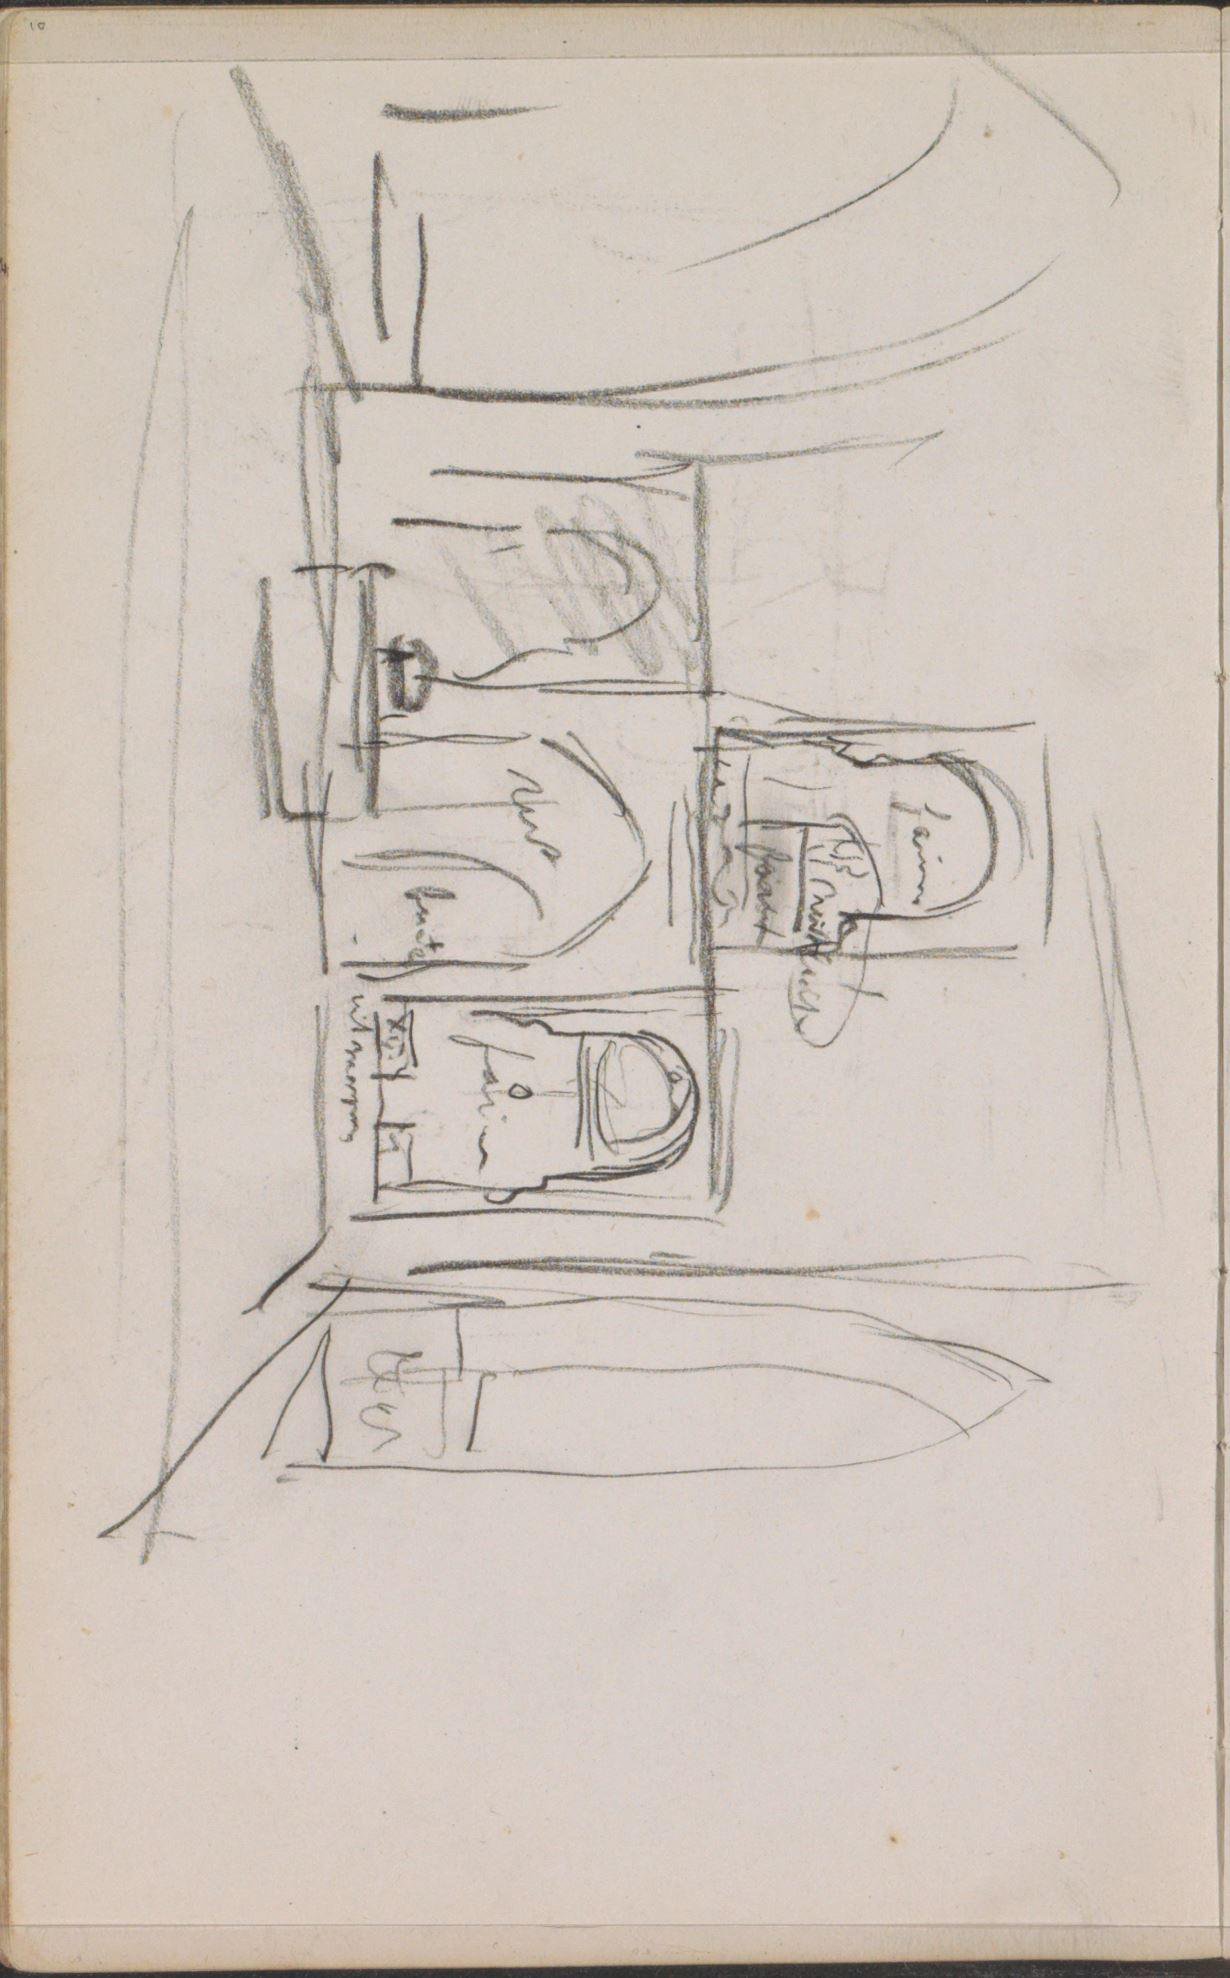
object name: sketchbook leaf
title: Interieur, mogelijk van een moskee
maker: marius bauer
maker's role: draughtsman, print maker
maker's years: 1867-1932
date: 1896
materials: chalk, paper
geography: istanbul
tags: temple, shrine ~ islam, mohammedanism, architecture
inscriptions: kleurnotitie, handgeschreven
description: Pagina 10 uit een schetsboek met 53 bladen.